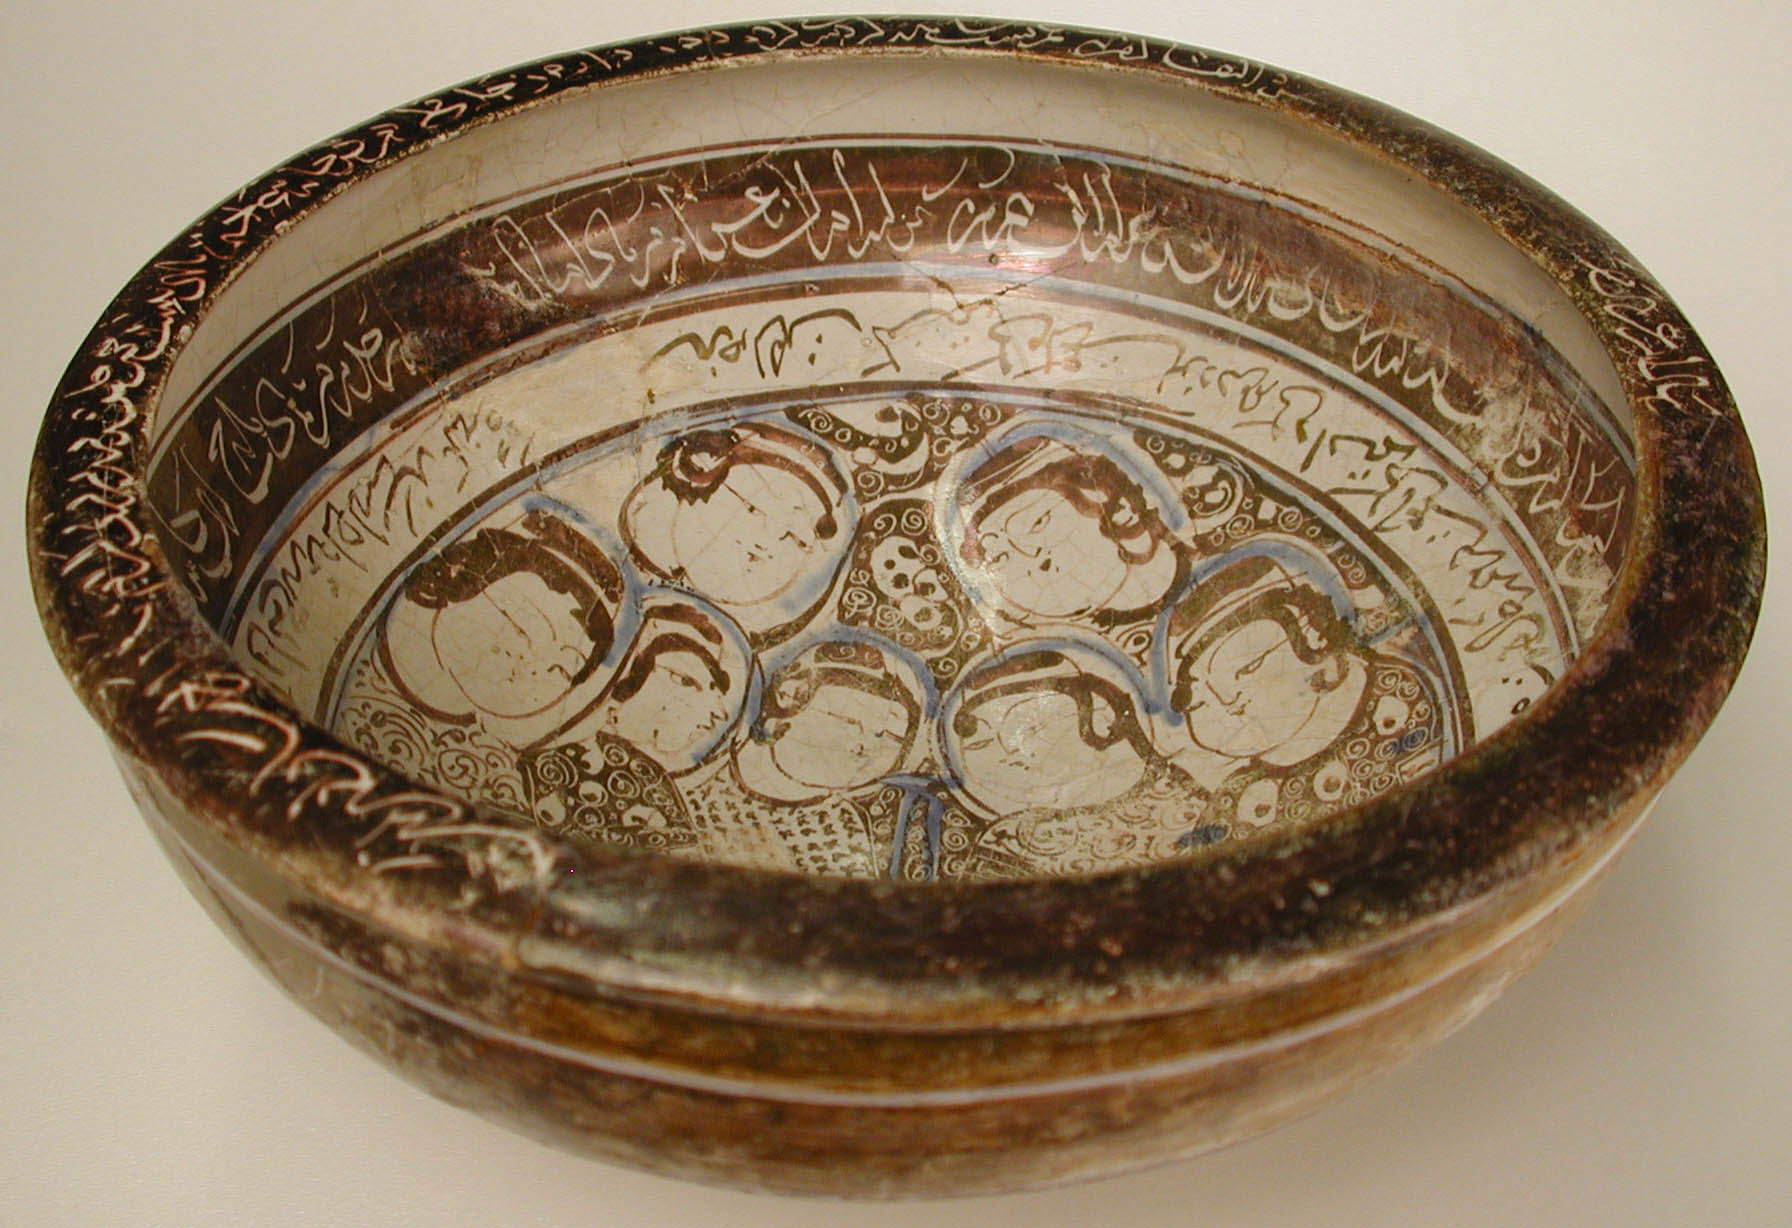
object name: bowl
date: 1201-1300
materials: glaze, stonepaste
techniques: luster painting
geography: iran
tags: faces